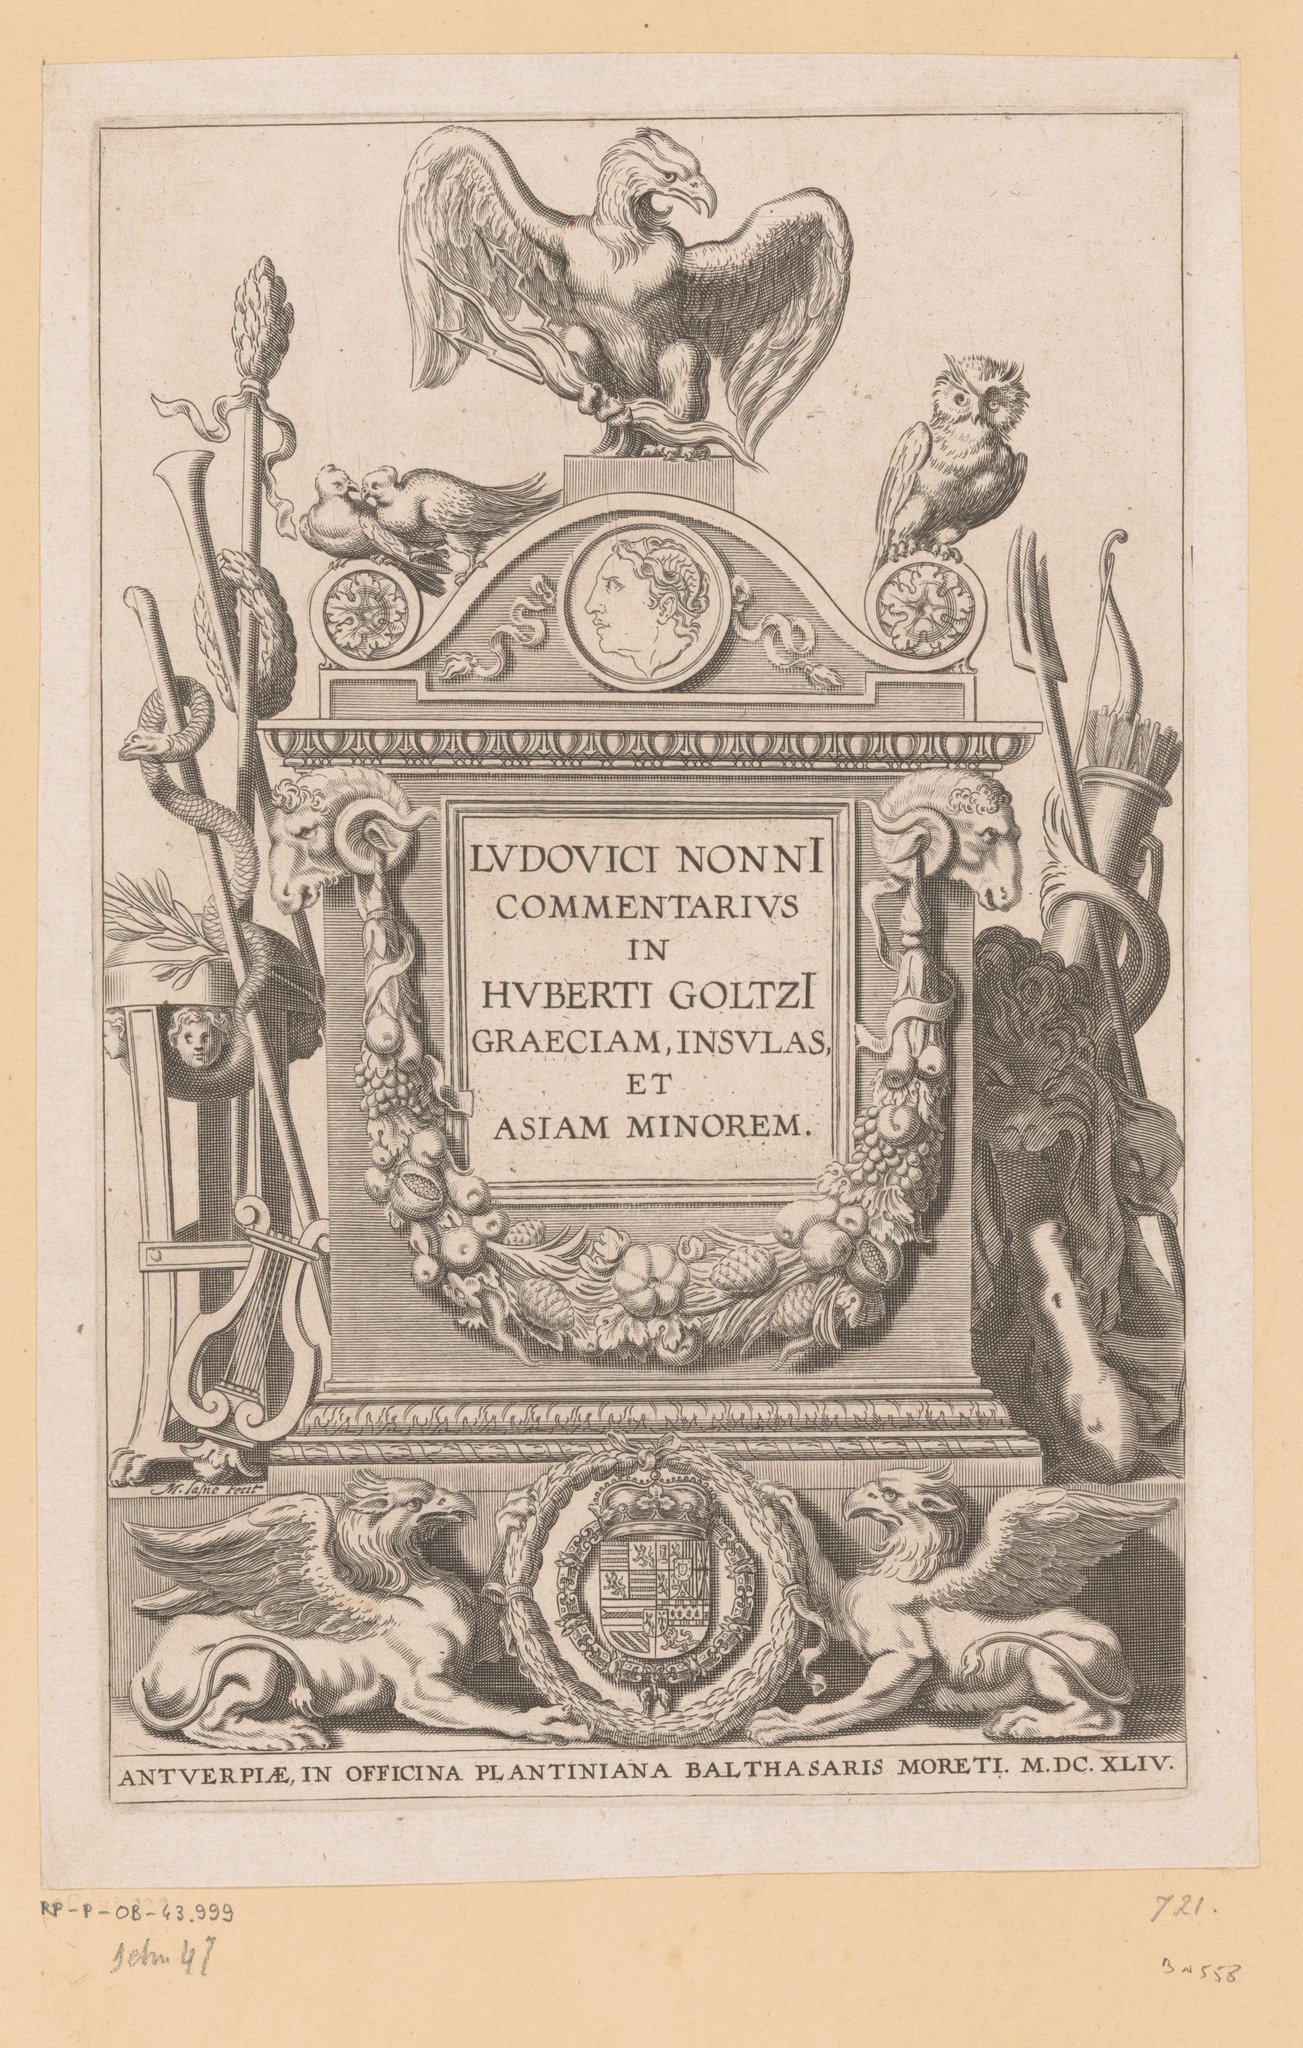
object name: print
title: Titelpagina voor: Ludovicus Nonnius, Commentarivs In Hvberti Goltzi Graeciam, Insvlas, Et Asiam Minorem, 1644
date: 1600-1641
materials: paper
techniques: engraving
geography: antwerp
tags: griffin (lion/eagle); 'griffo' (ripa), altar ~ greek religion, attributes of minerva: owl, attributes of jupiter: eagle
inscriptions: collector's mark: Lugt 240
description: Titelpagina voor: Nonnius, Ludovicus. Commentarivs In Hvberti Goltzi Graeciam, Insvlas, Et Asiam Minorem. Antwerpen: Balthasar (I) Moretus, 1644. De prent werd initieel gebruikt als titelpagina voor de 'Graeciae universae Asiaeque Minoris et Insularum Nomismata', uitgegeven door Jacques de Bie in 1618 te Antwerpen.